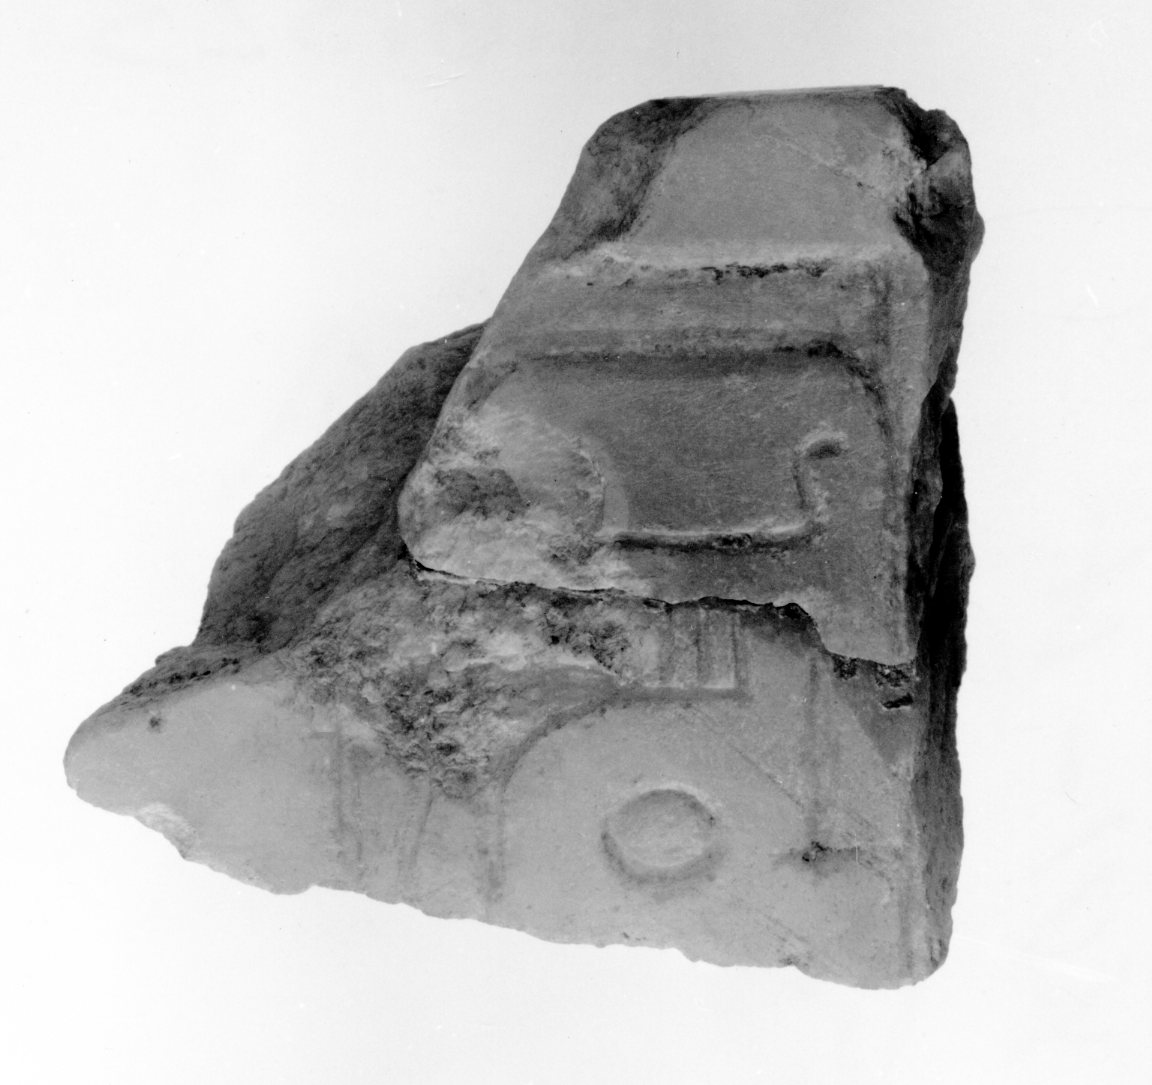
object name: canopic chest fragment, siptah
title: Fragment of the Upper Right Corner of One Side of Siptah's Canopic Box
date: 1194-1188 BCE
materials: stone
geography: egypt